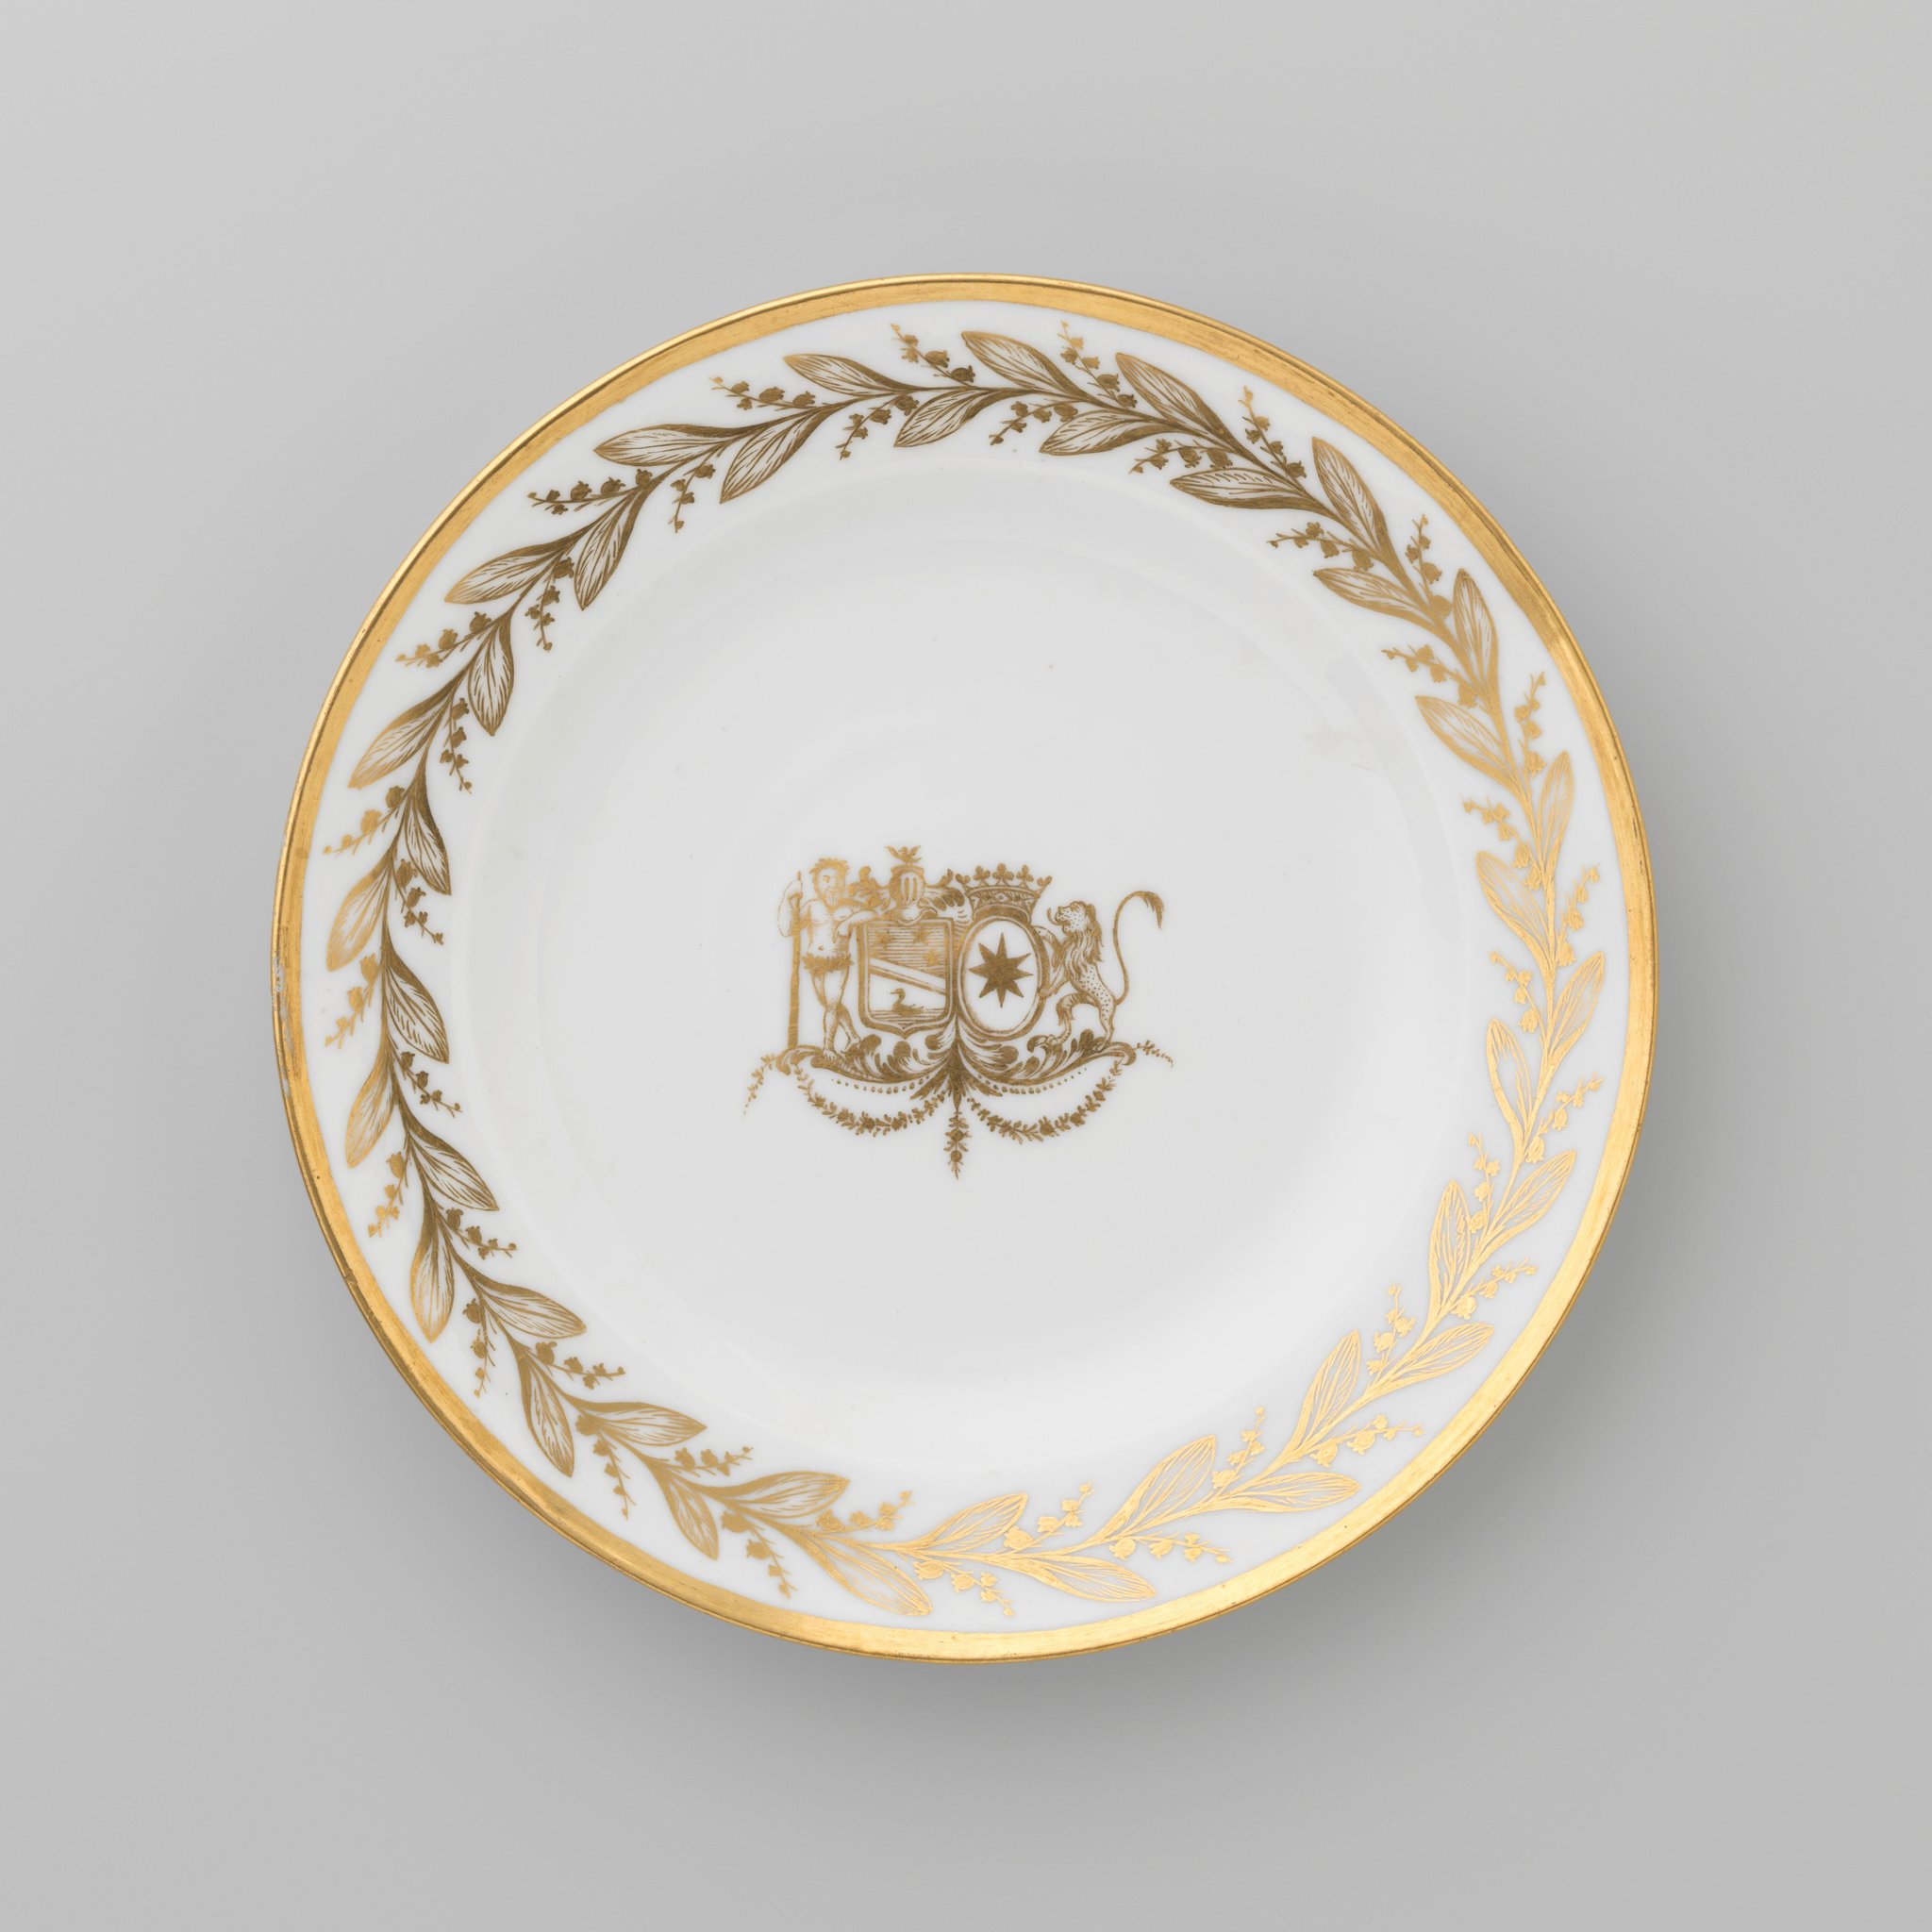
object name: service set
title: Plate with the coat of arms of Hendrik Peter Godfried Quack and Isabella Gertraud von Carnap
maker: Anonymous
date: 1790-1800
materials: glaze, gold, paint, porcelain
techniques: firing, forming, gilding, turning, vitrification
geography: netherlands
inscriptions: mark: ‘N’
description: Bord van porselein, beschilderd op het glazuur met goud. Op het plat het alliantiewapen van Hendrik Peter Godfried Quack en Isabella Gertraud von Carnap. De rand met een bloemrank en een gouden band. Drie proenen op de onderzijde. Gemerkt op de onderzijde met N.